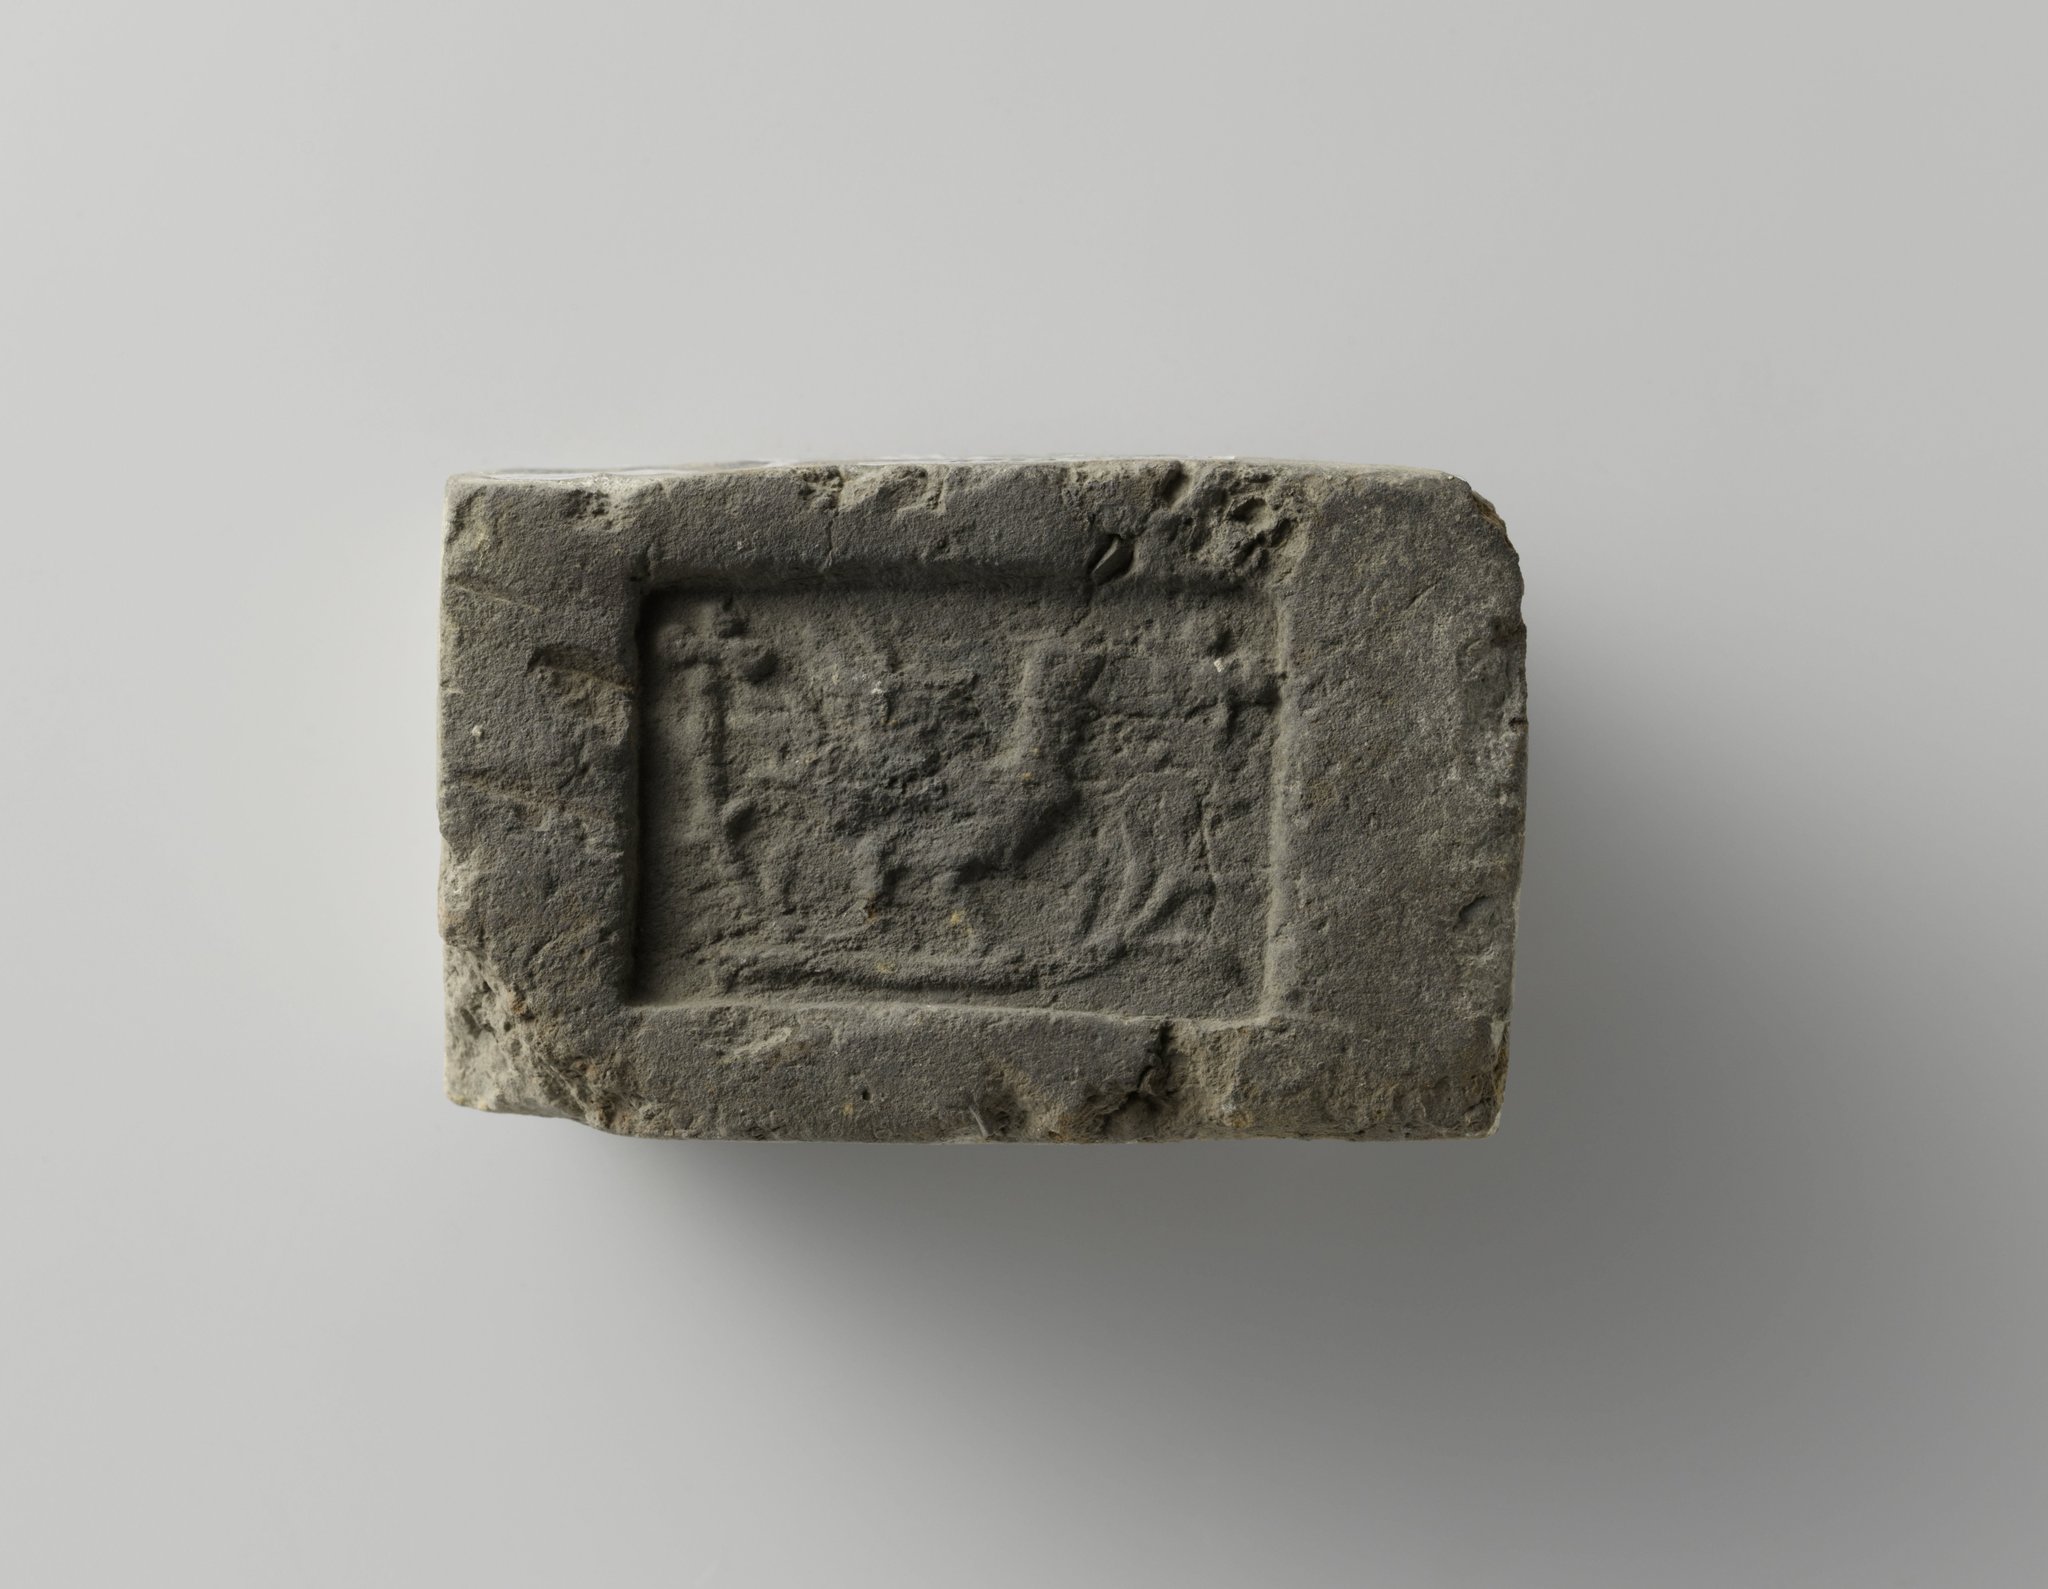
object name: architectural element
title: Haardsteen, waarop een vogel op een tak en twee klaverbladen in de hoeken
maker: Anonymous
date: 1500-1600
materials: earthenware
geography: southern netherlands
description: Haardsteen, waarop een vogel op een tak en twee klaverbladen in de hoeken. Van fijne gebakken aarde.